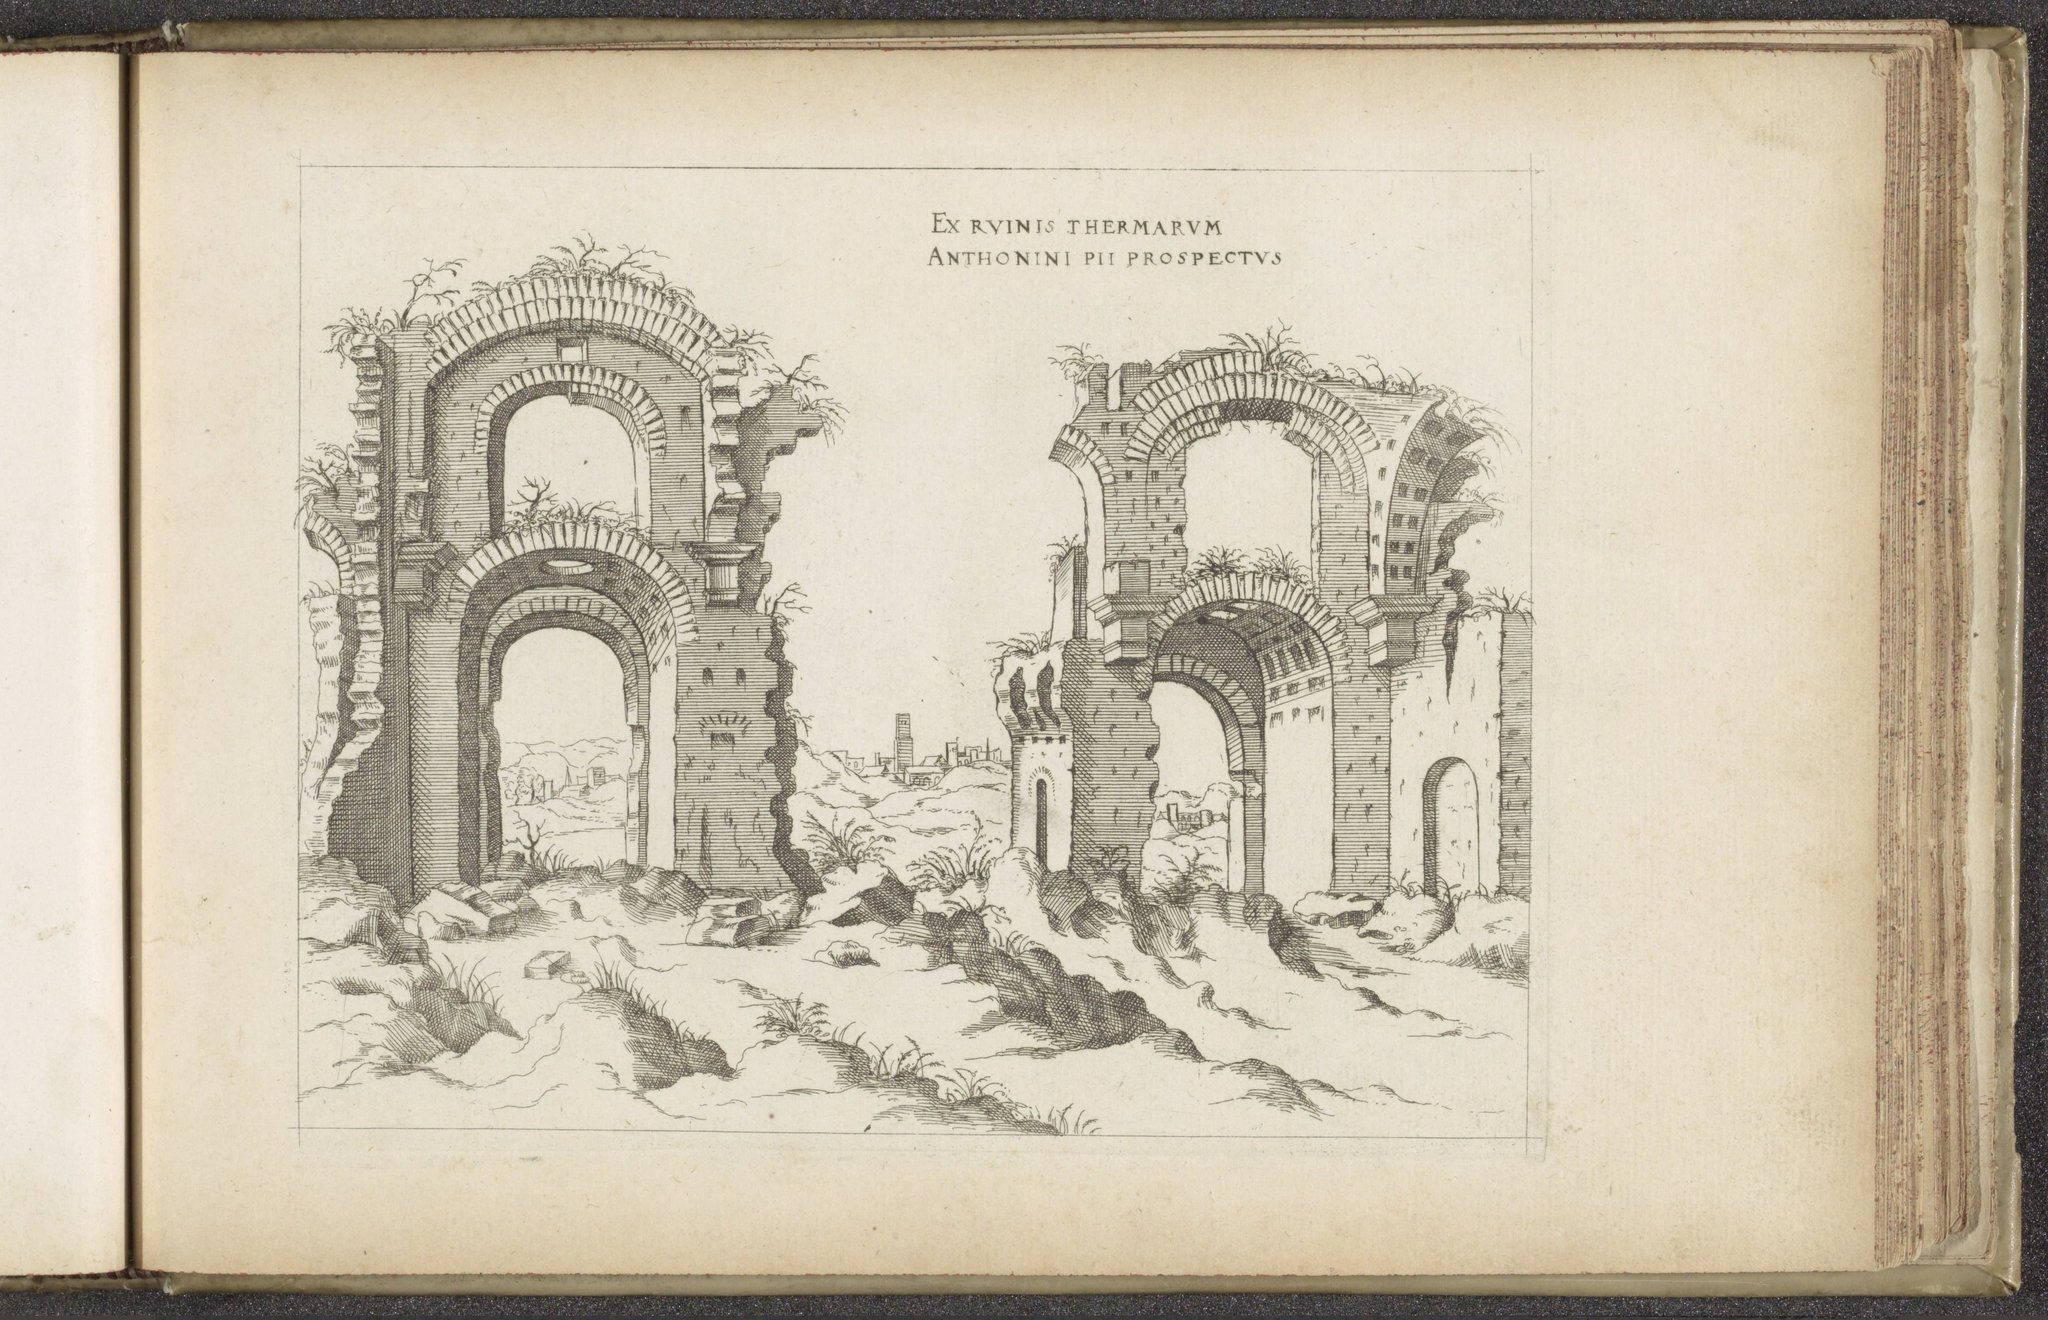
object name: album leaf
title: Praecipva Aliqvot Romanae Antiqvitatis Rvinarum Monimenta Vivis Prospectibus Ad Veri Imitationem Affabre Designata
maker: jacques androuet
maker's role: draughtsman, print maker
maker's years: 1515-1584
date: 1551-1584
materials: paper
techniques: etching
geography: france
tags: ruin of a building ~ architecture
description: Tweede gezicht op de ruïnes van de Thermen van Diocletianus in Rome. Deze prent maakt deel uit van een album.